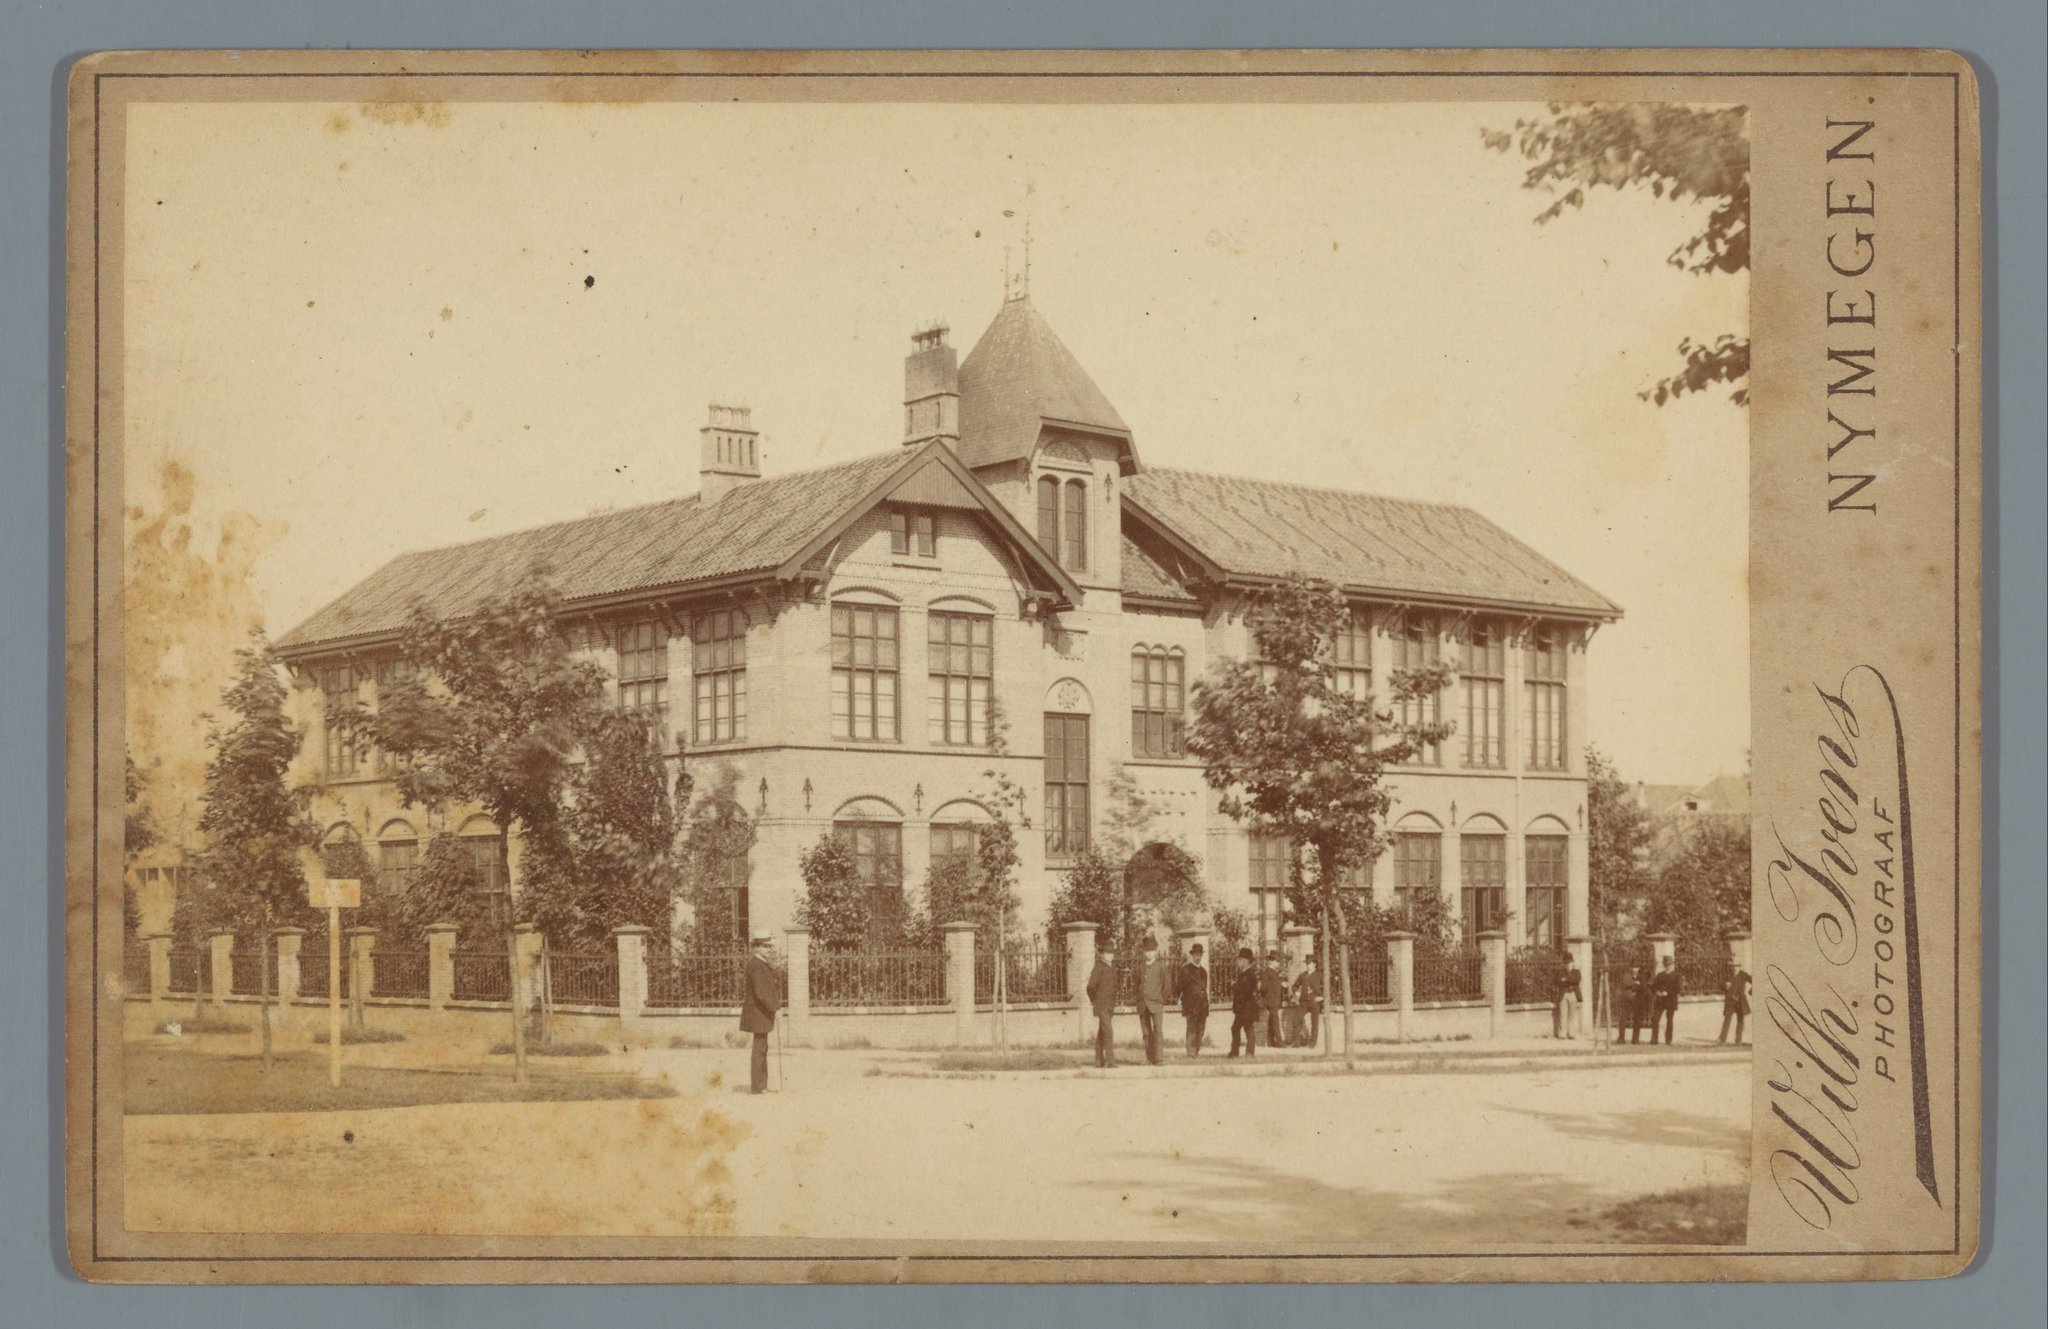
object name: photograph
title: Groepsportret bij de Kweekschool voor onderwijzers te Nijmegen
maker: wilhelm ivens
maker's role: fotograaf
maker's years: 1849-1904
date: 1850-1900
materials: cardboard, photographic support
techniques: albumen print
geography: nijmegen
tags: secondary education, nijmegen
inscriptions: inscription: ‘Kweekschool - Nijmegen/ no 1 van. links Fransen (leraar gymnasium/ no 5 " " B. Mulder’